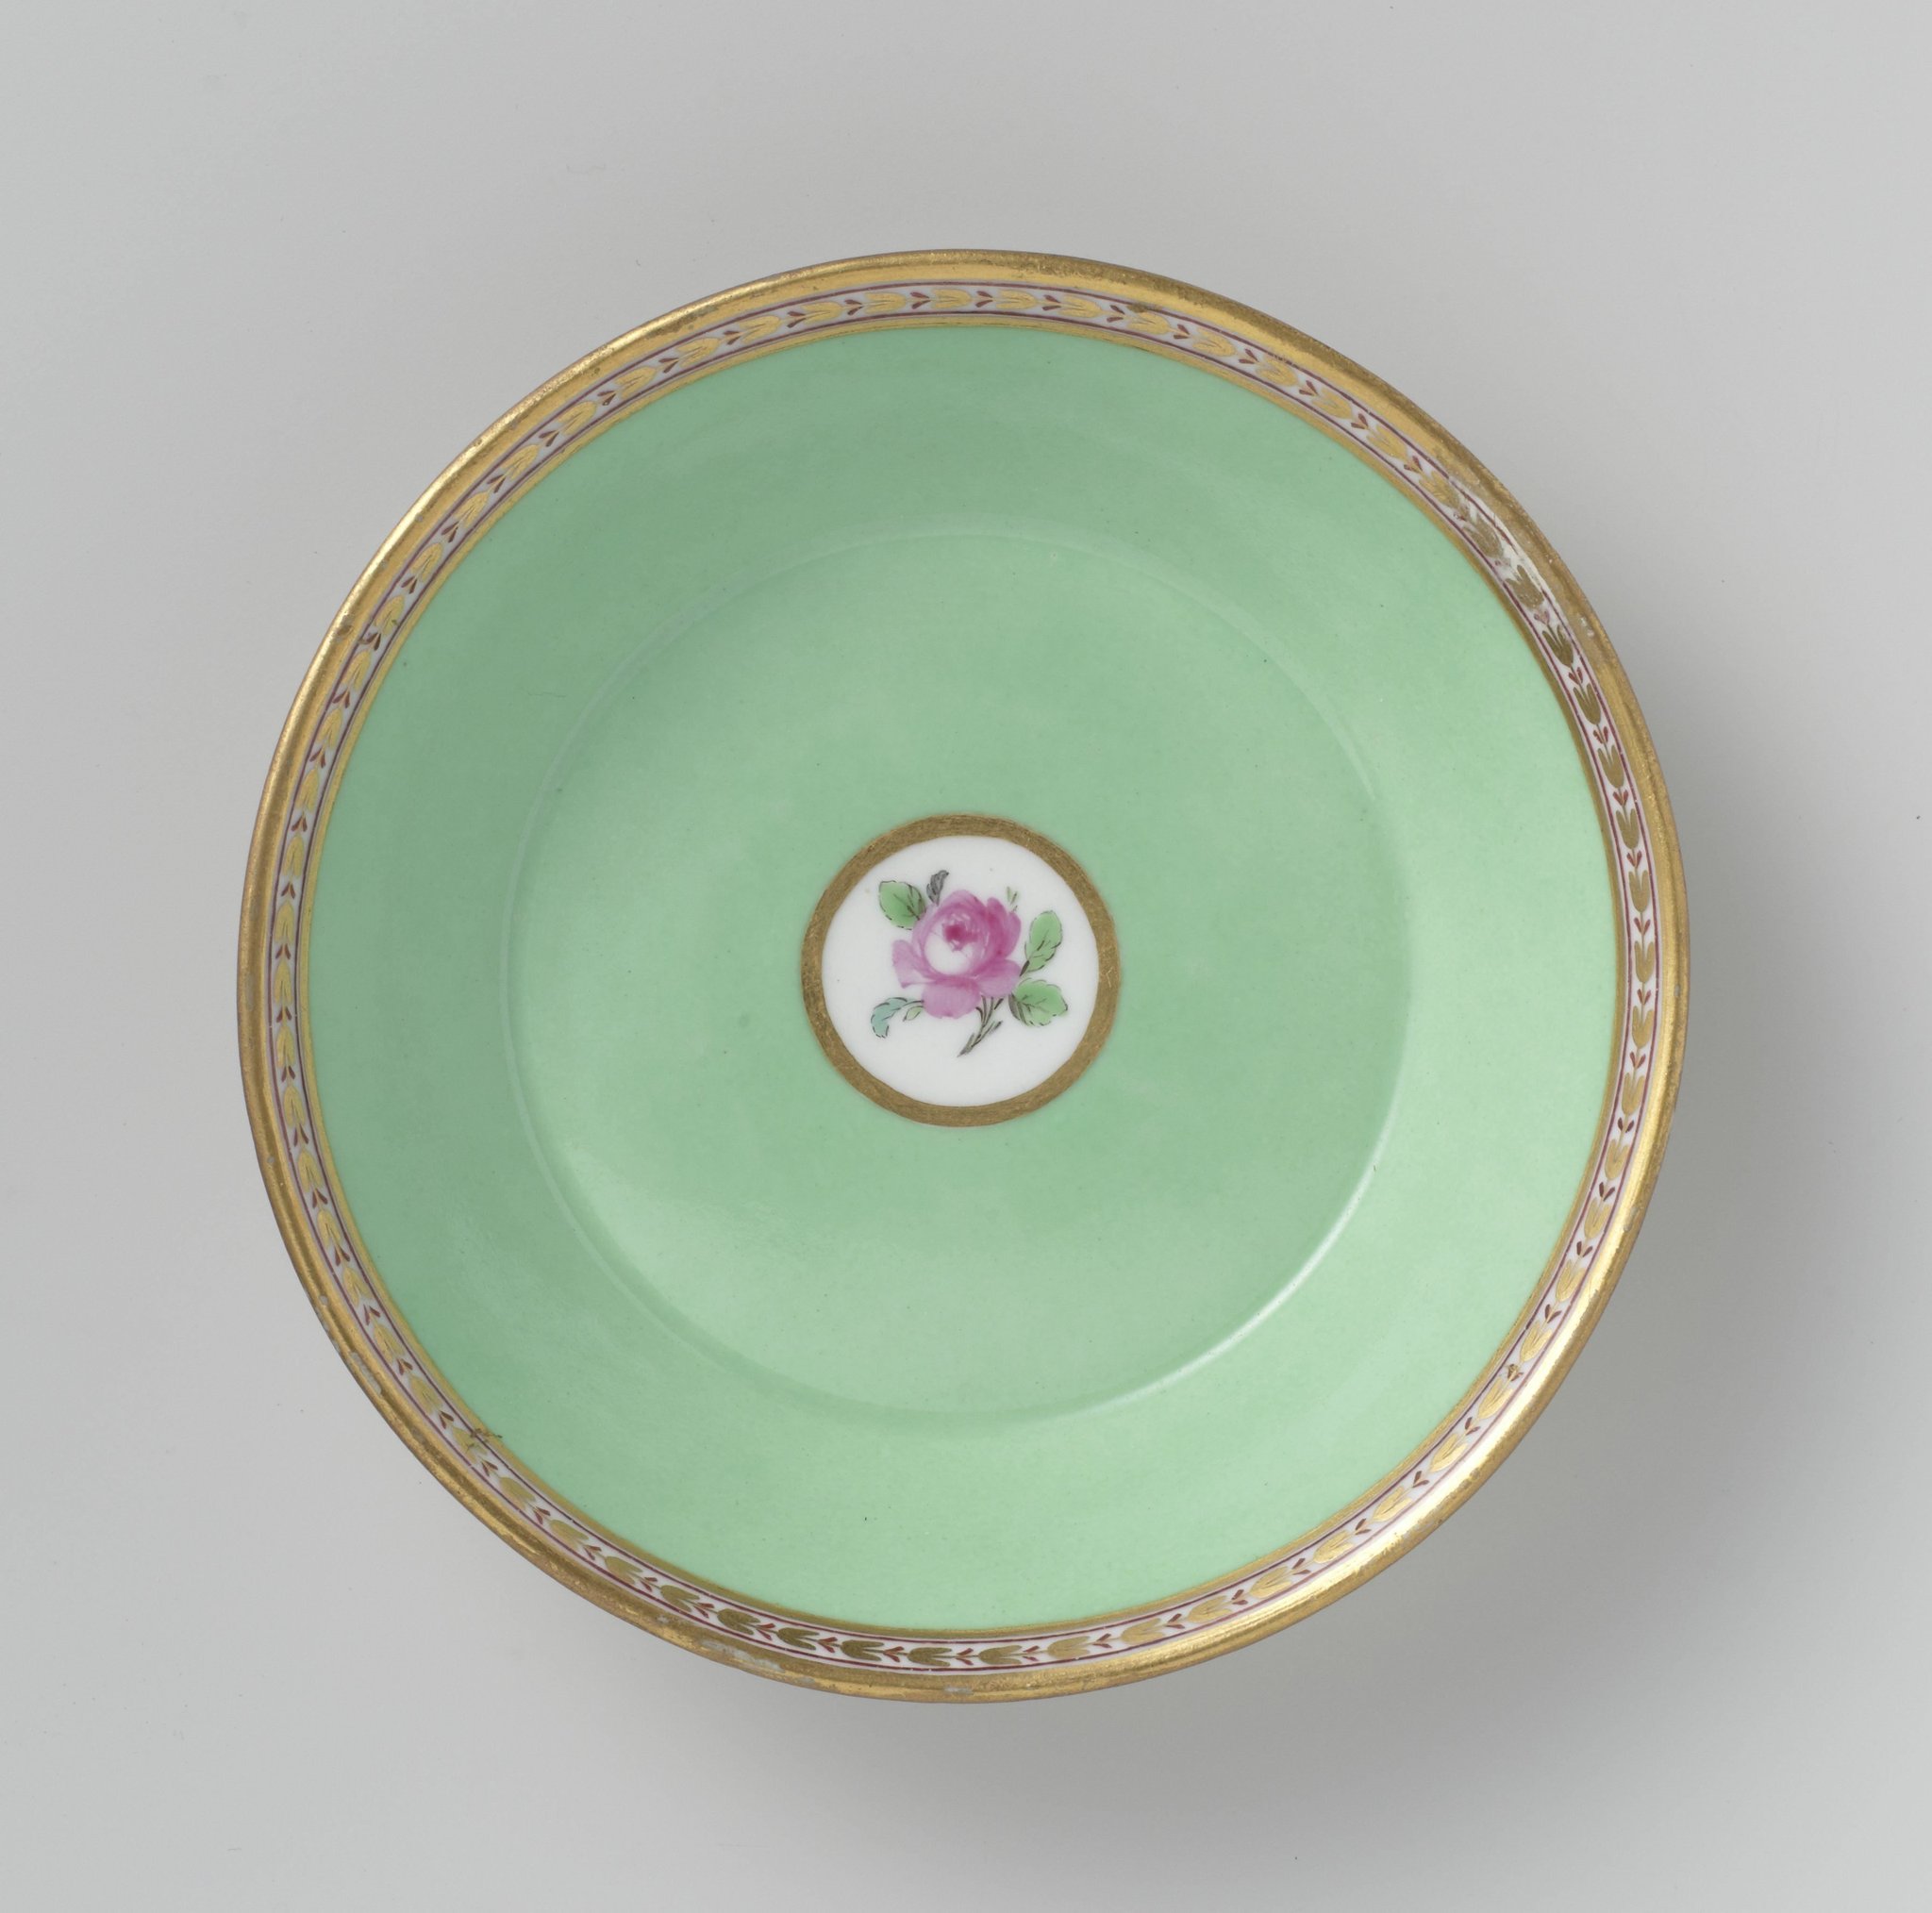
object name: platter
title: Saucer with roses in a basket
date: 1795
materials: glaze, gold, porcelain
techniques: firing, forming, gilding, turning, vitrification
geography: berlin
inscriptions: mark: ‘scepter/ O[b?]/ II’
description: Parts of a tea and coffee service. Porcelain. Berlin, c. 1790 - 1800.